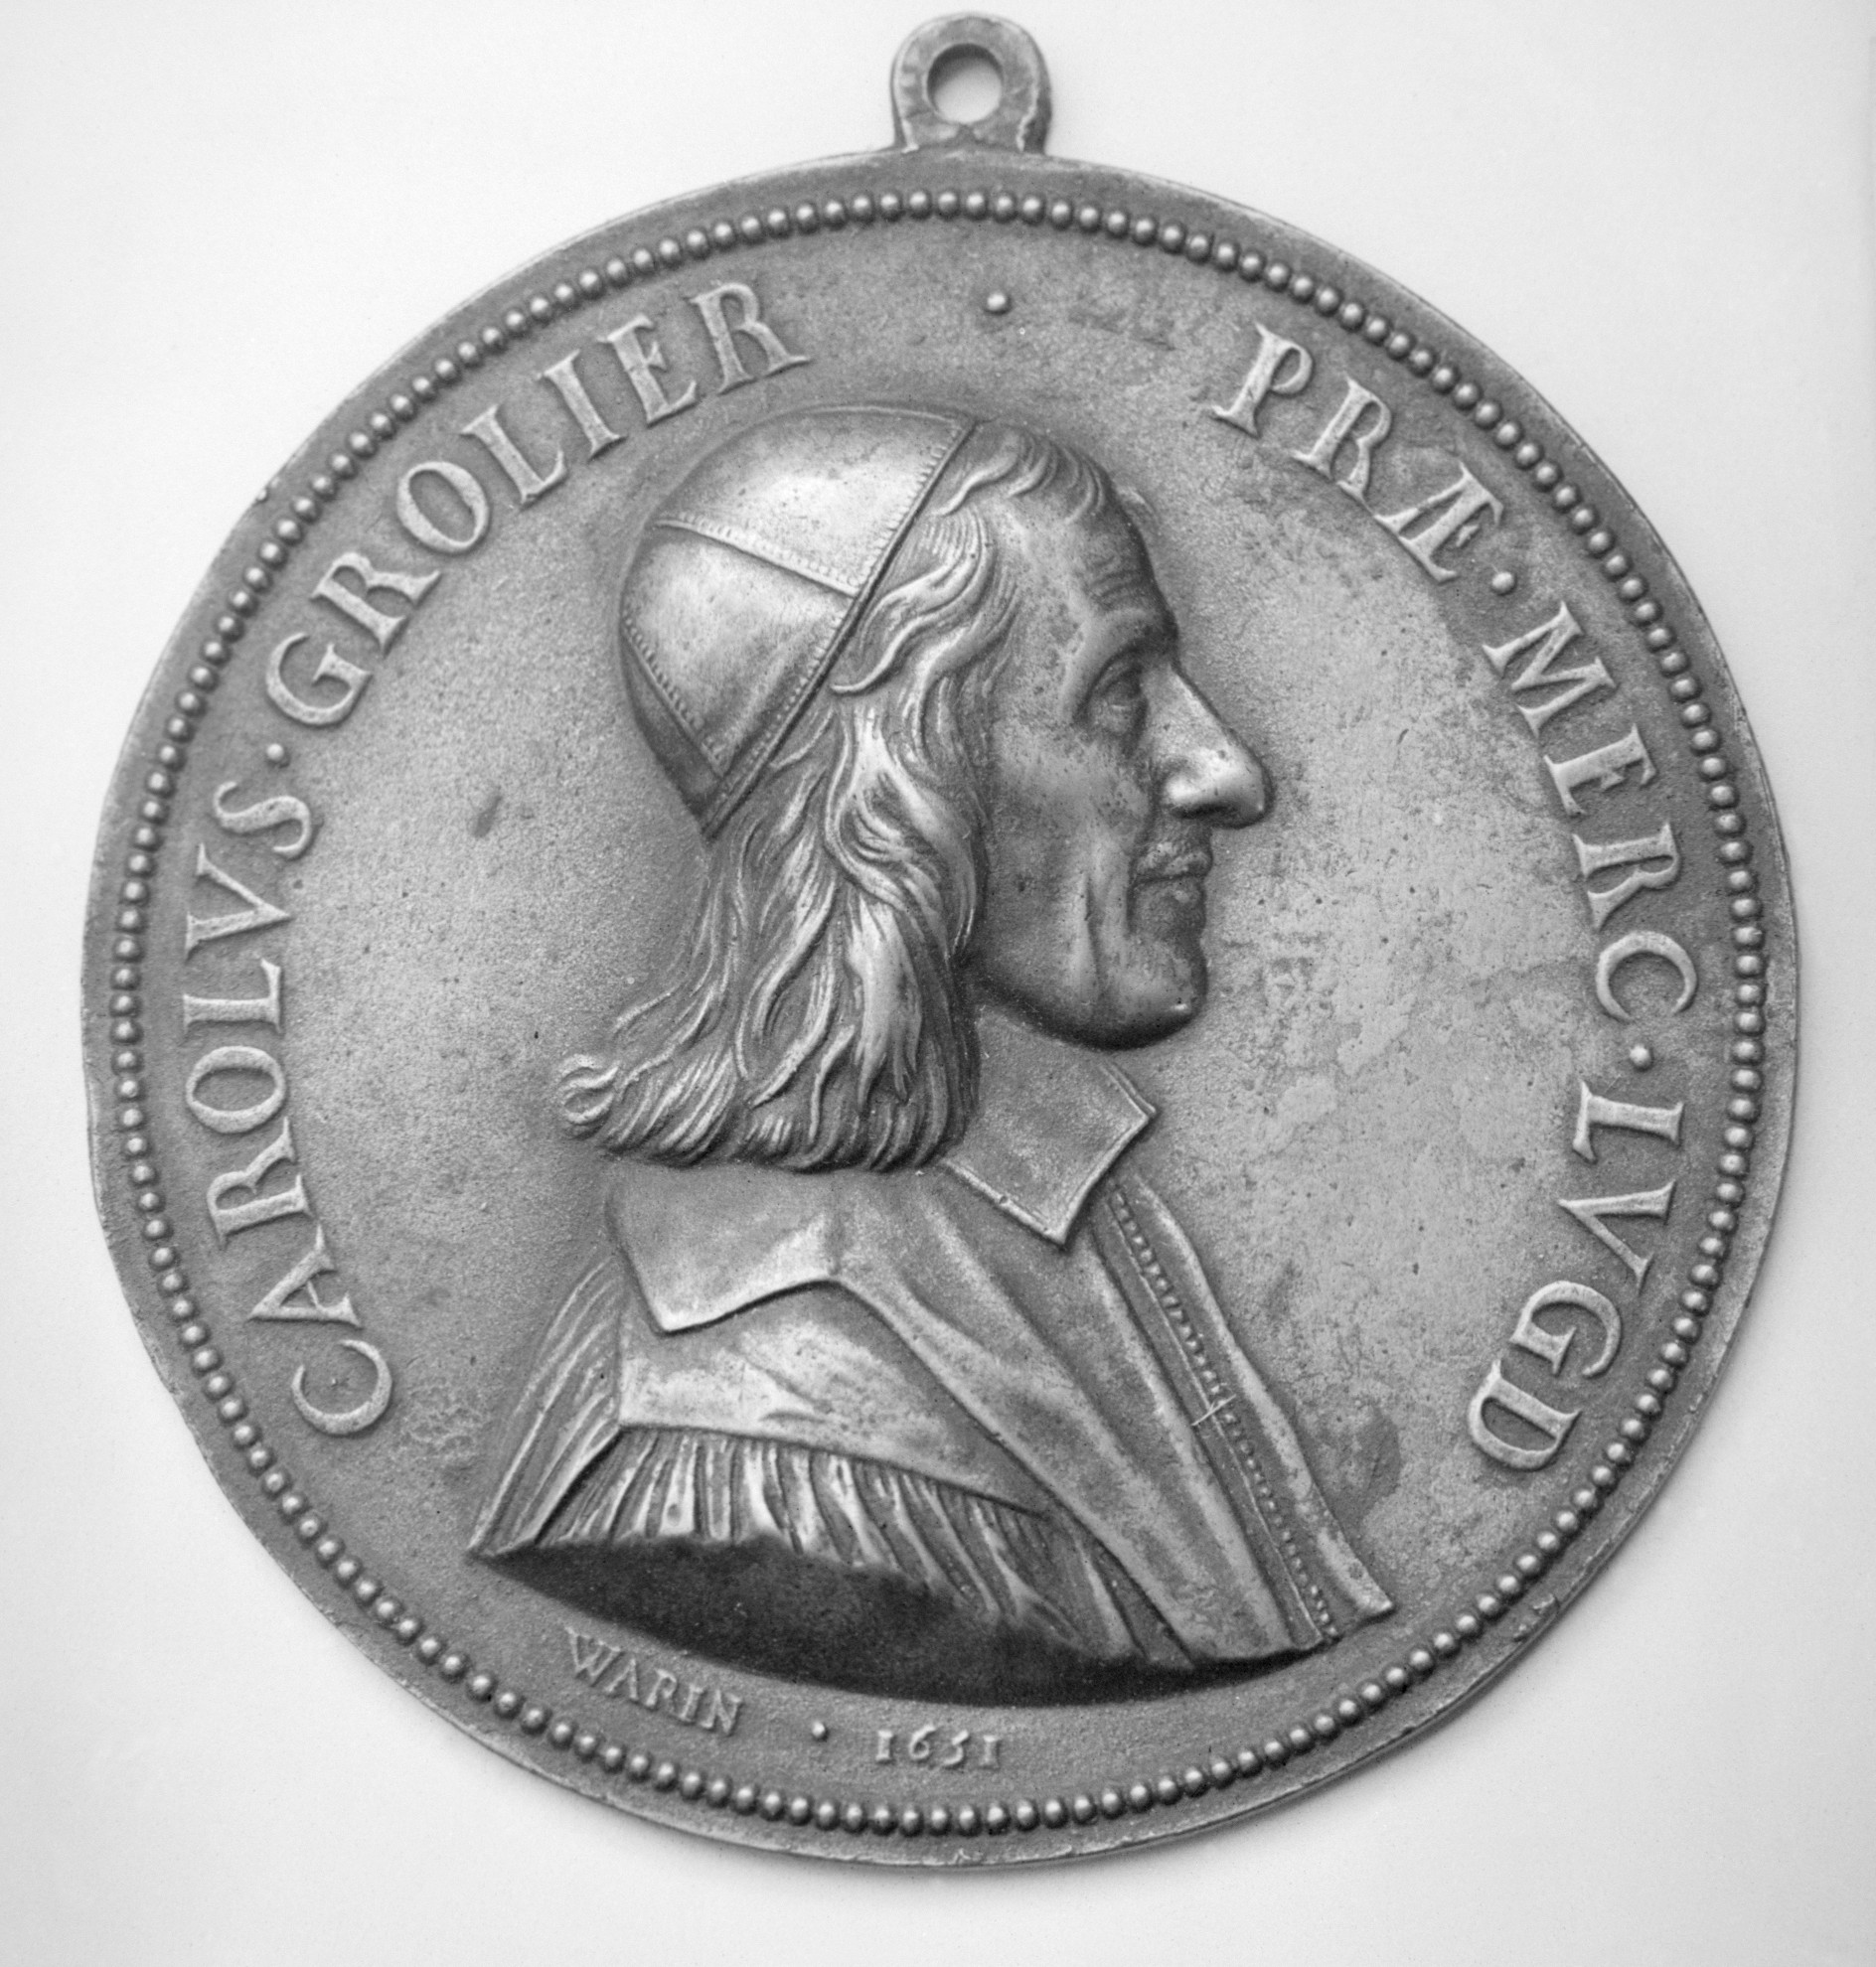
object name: medal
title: Charles Grolier, provost of the merchants of Lyon (1650–73)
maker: claude varin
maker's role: artist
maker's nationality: french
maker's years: 1630-1654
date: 1651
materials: bronze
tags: men,profiles